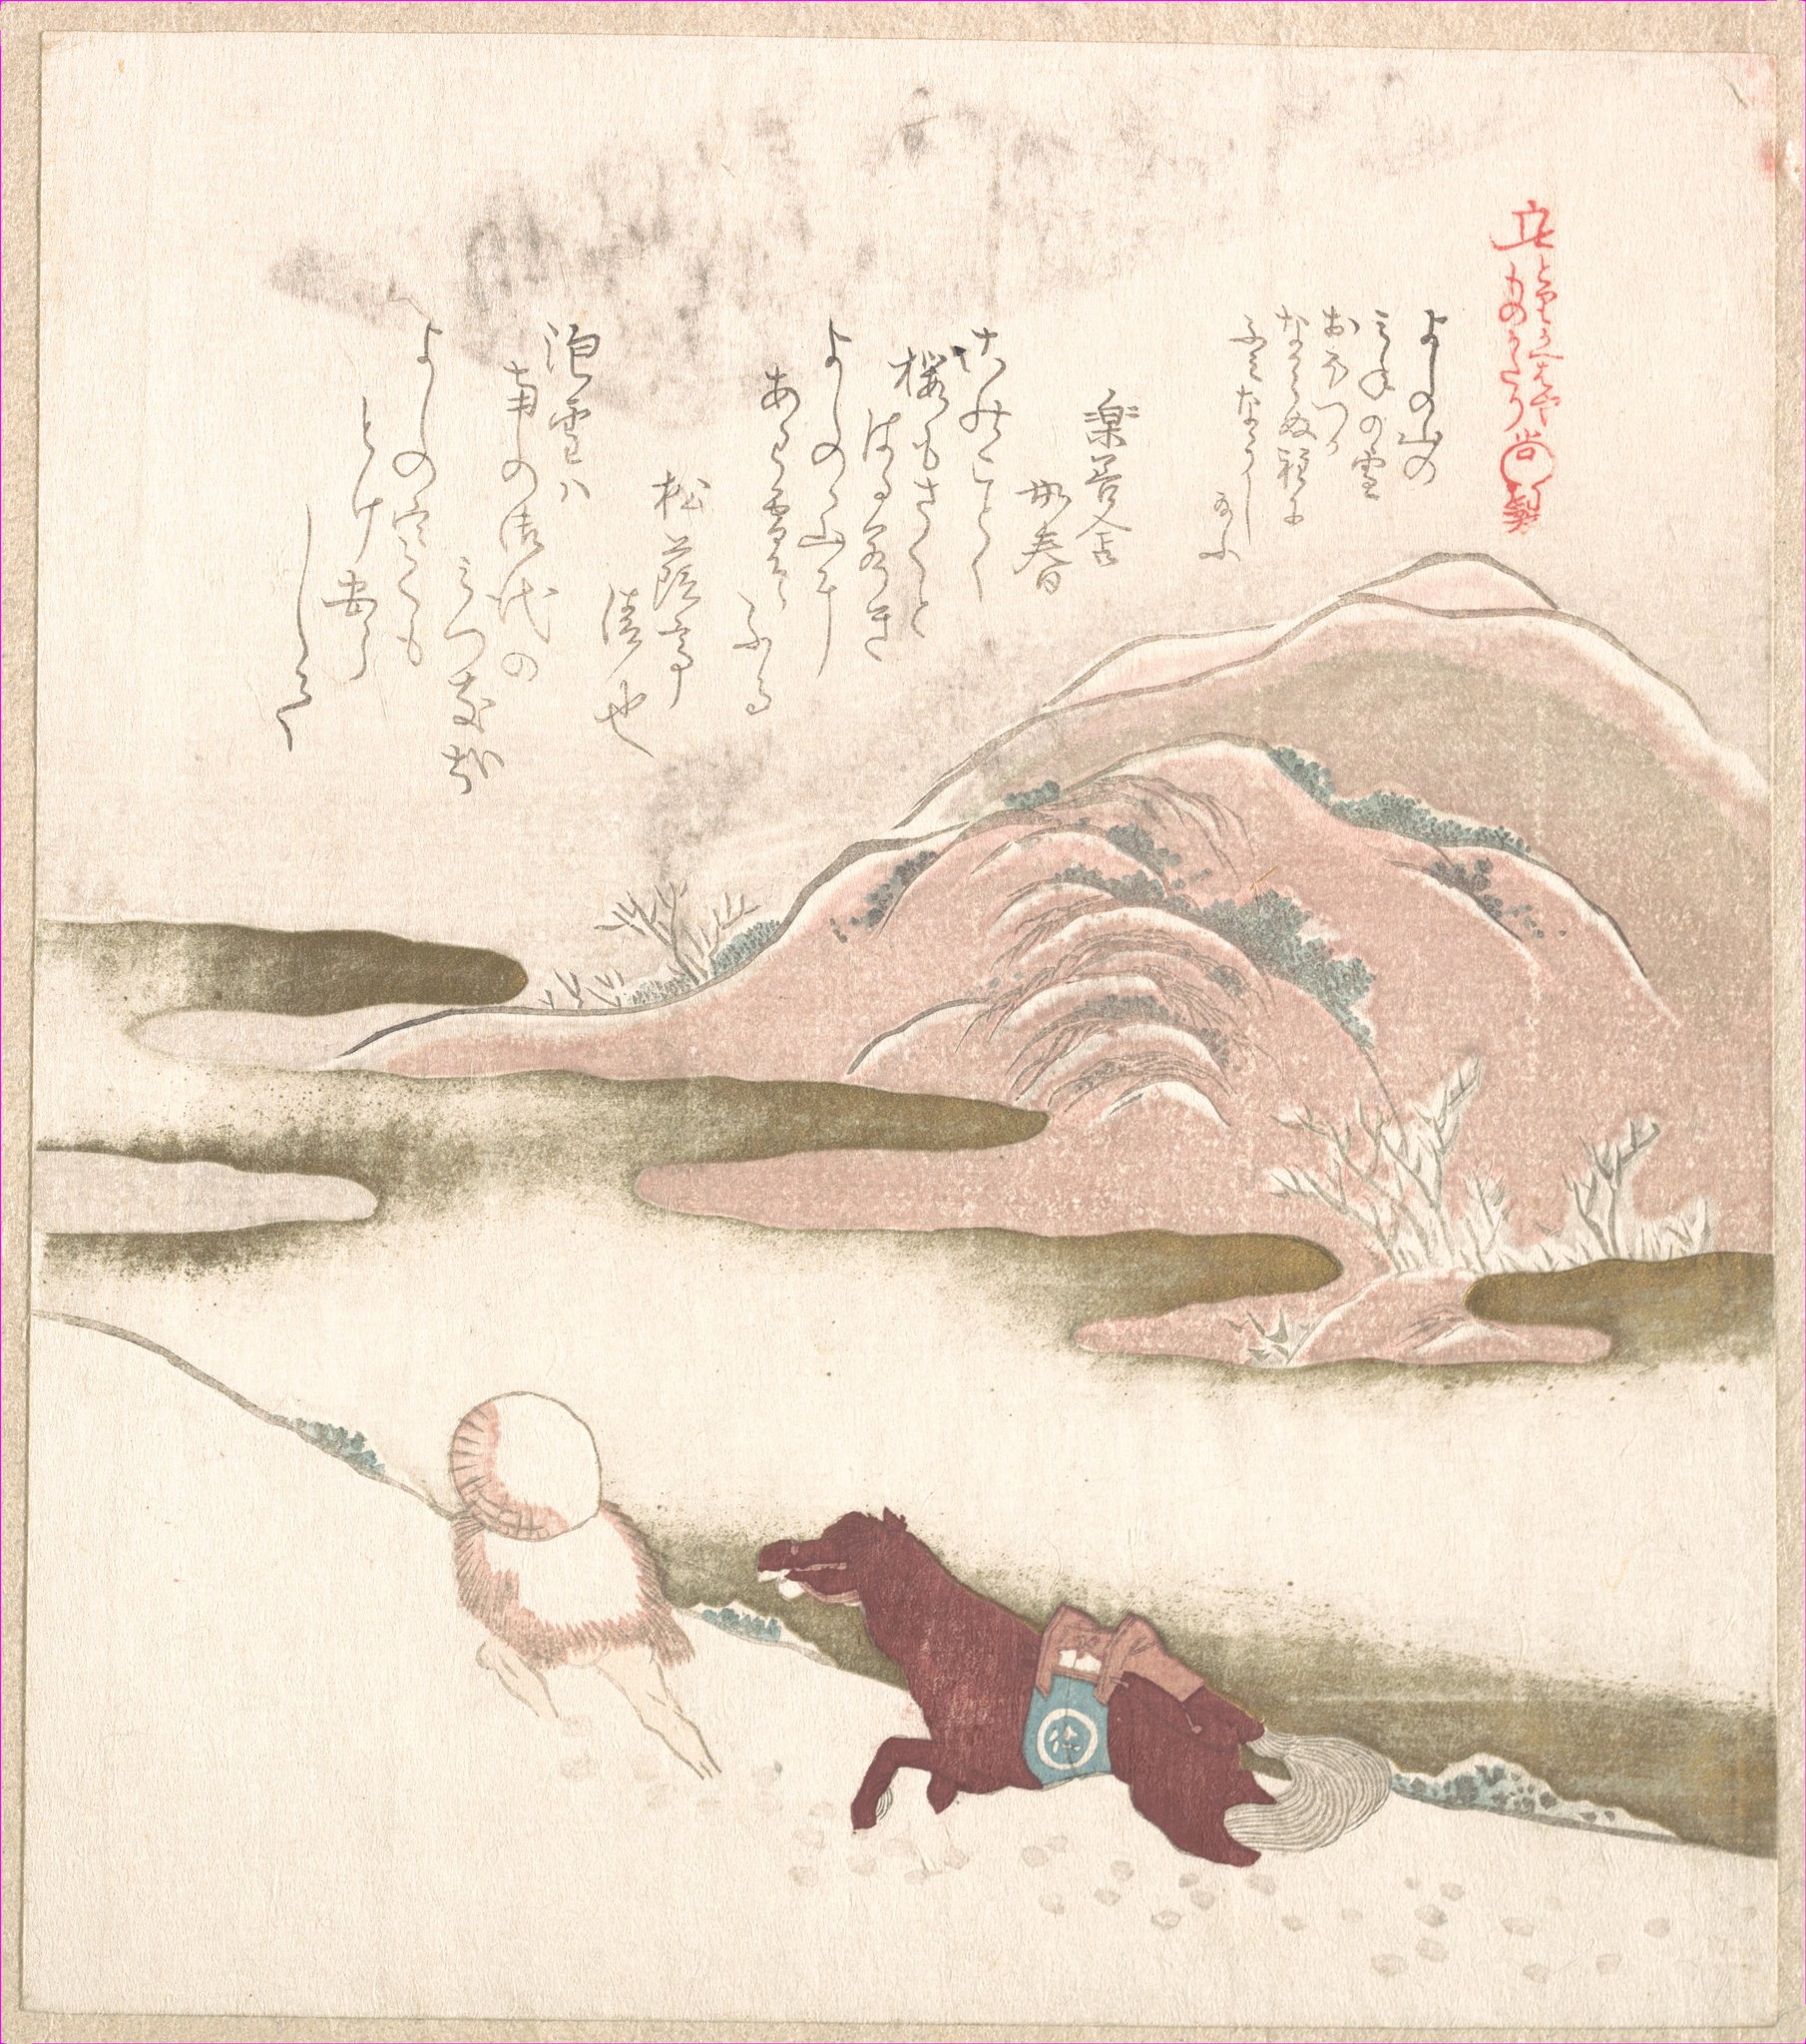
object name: print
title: Snowy Landscape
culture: japanese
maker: kubo shunman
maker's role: artist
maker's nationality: japanese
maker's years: 1757-1820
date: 1801-1900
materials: ink, paper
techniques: surimono, woodblock print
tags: horses,hills,landscapes,snow